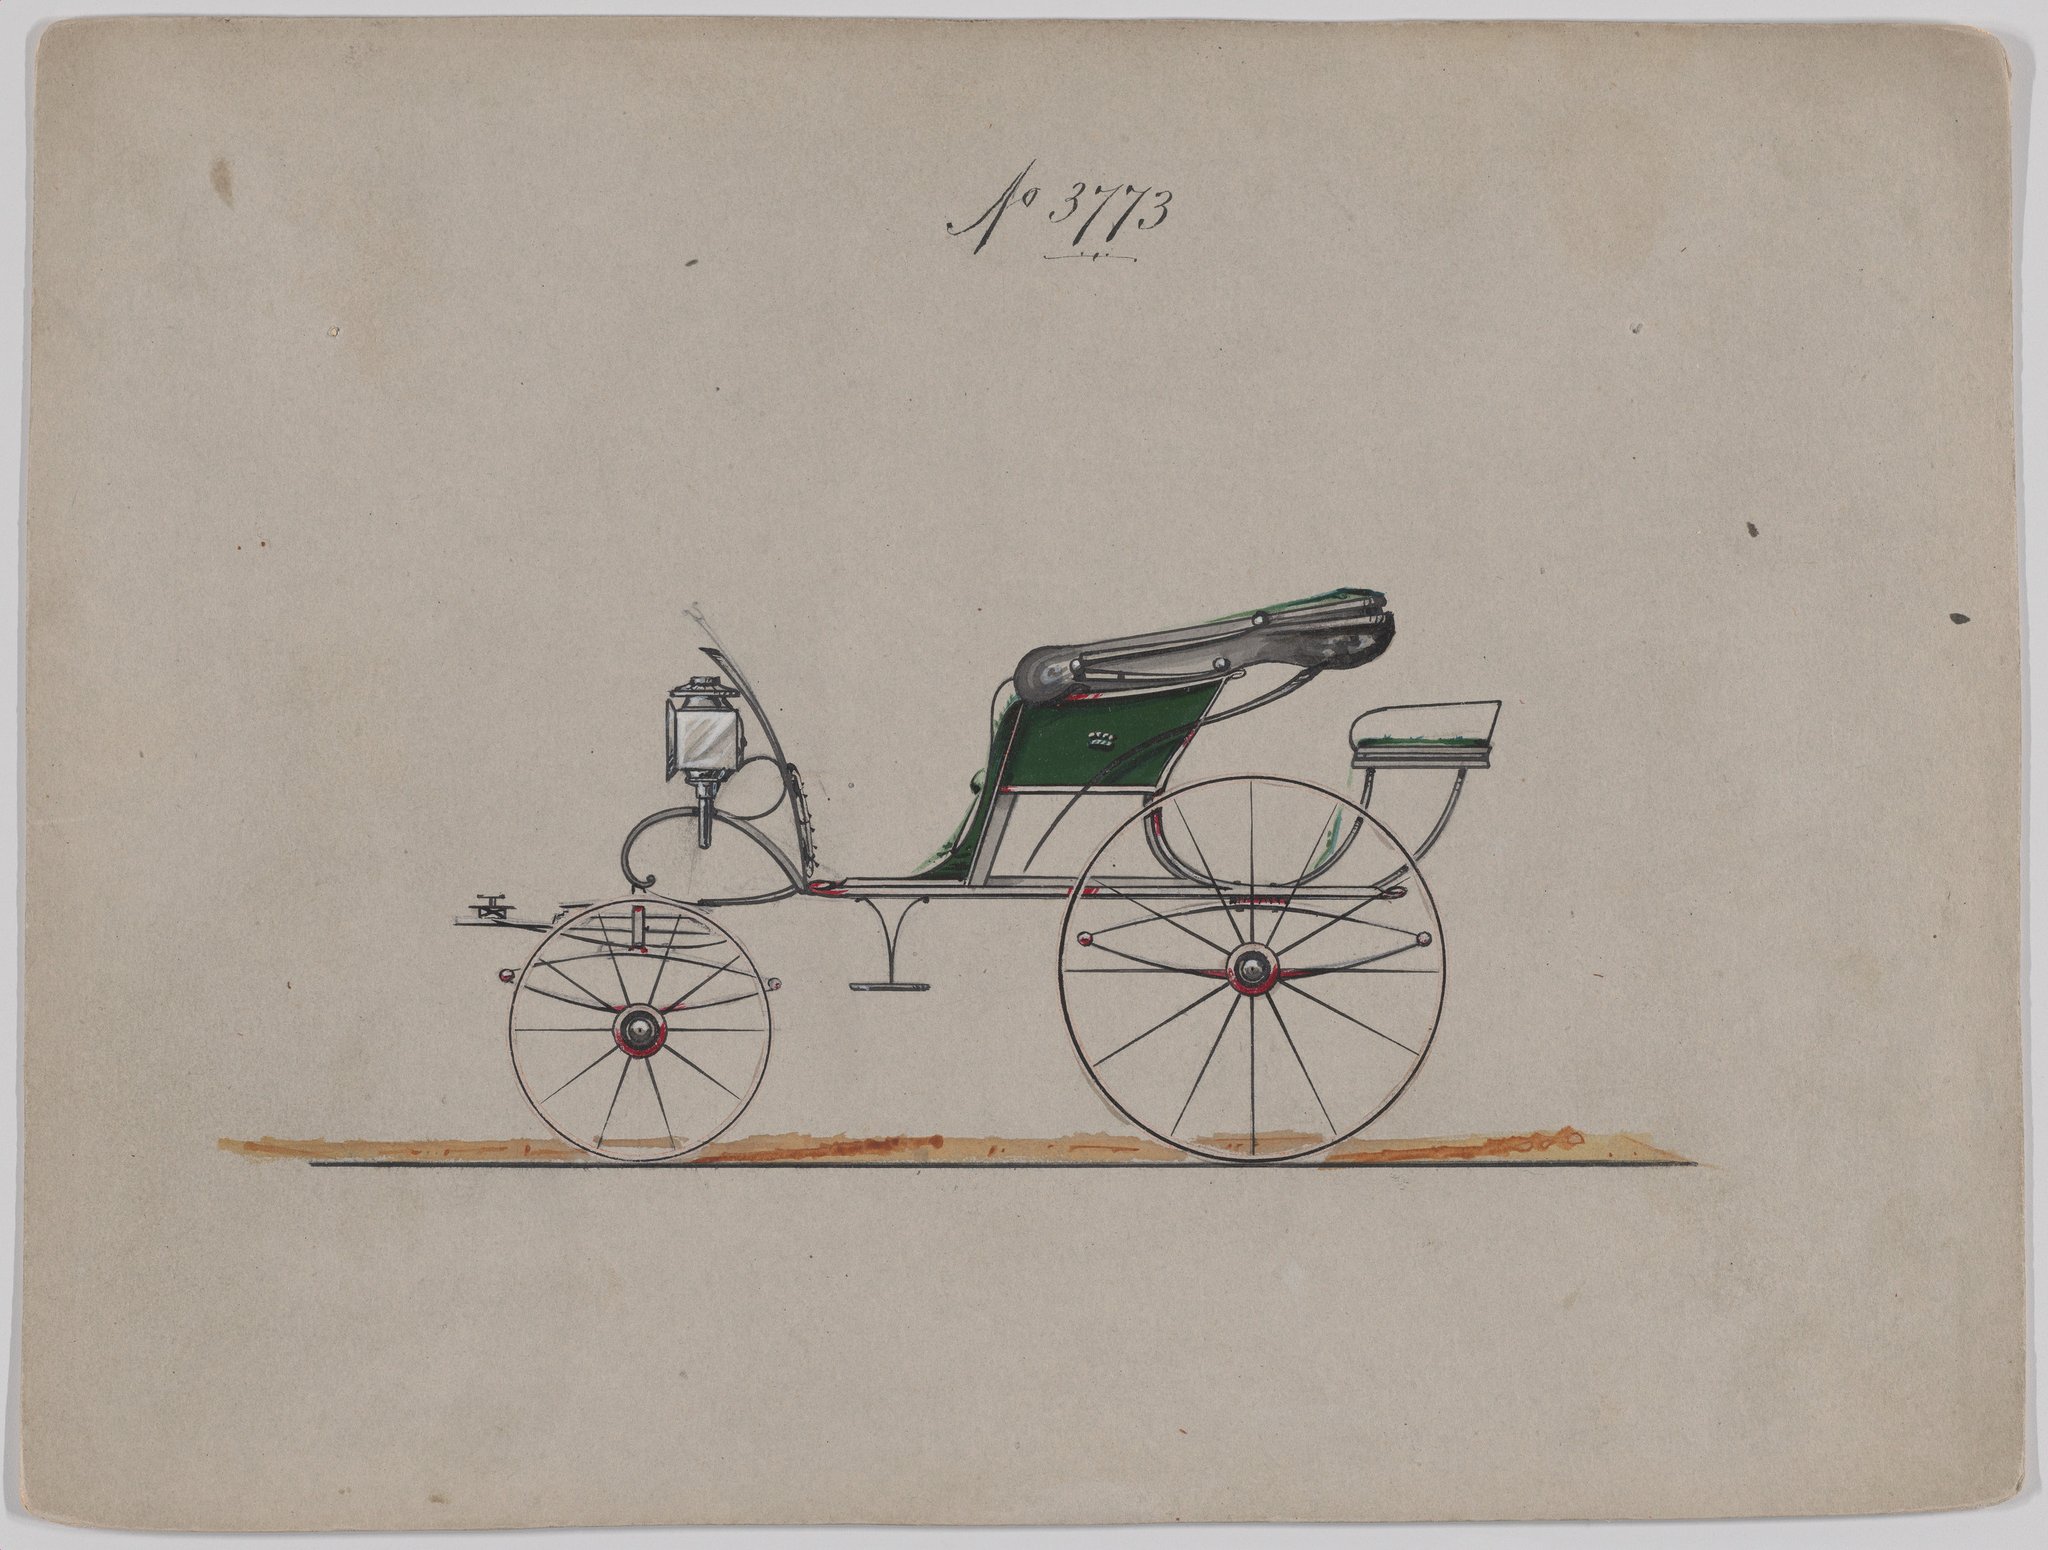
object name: drawing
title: Design for Pony Phaeton, no. 3773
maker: brewster & co.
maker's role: manufacturer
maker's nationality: american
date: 1882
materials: gouache, gum arabic, ink, watercolor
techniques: pen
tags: carriages